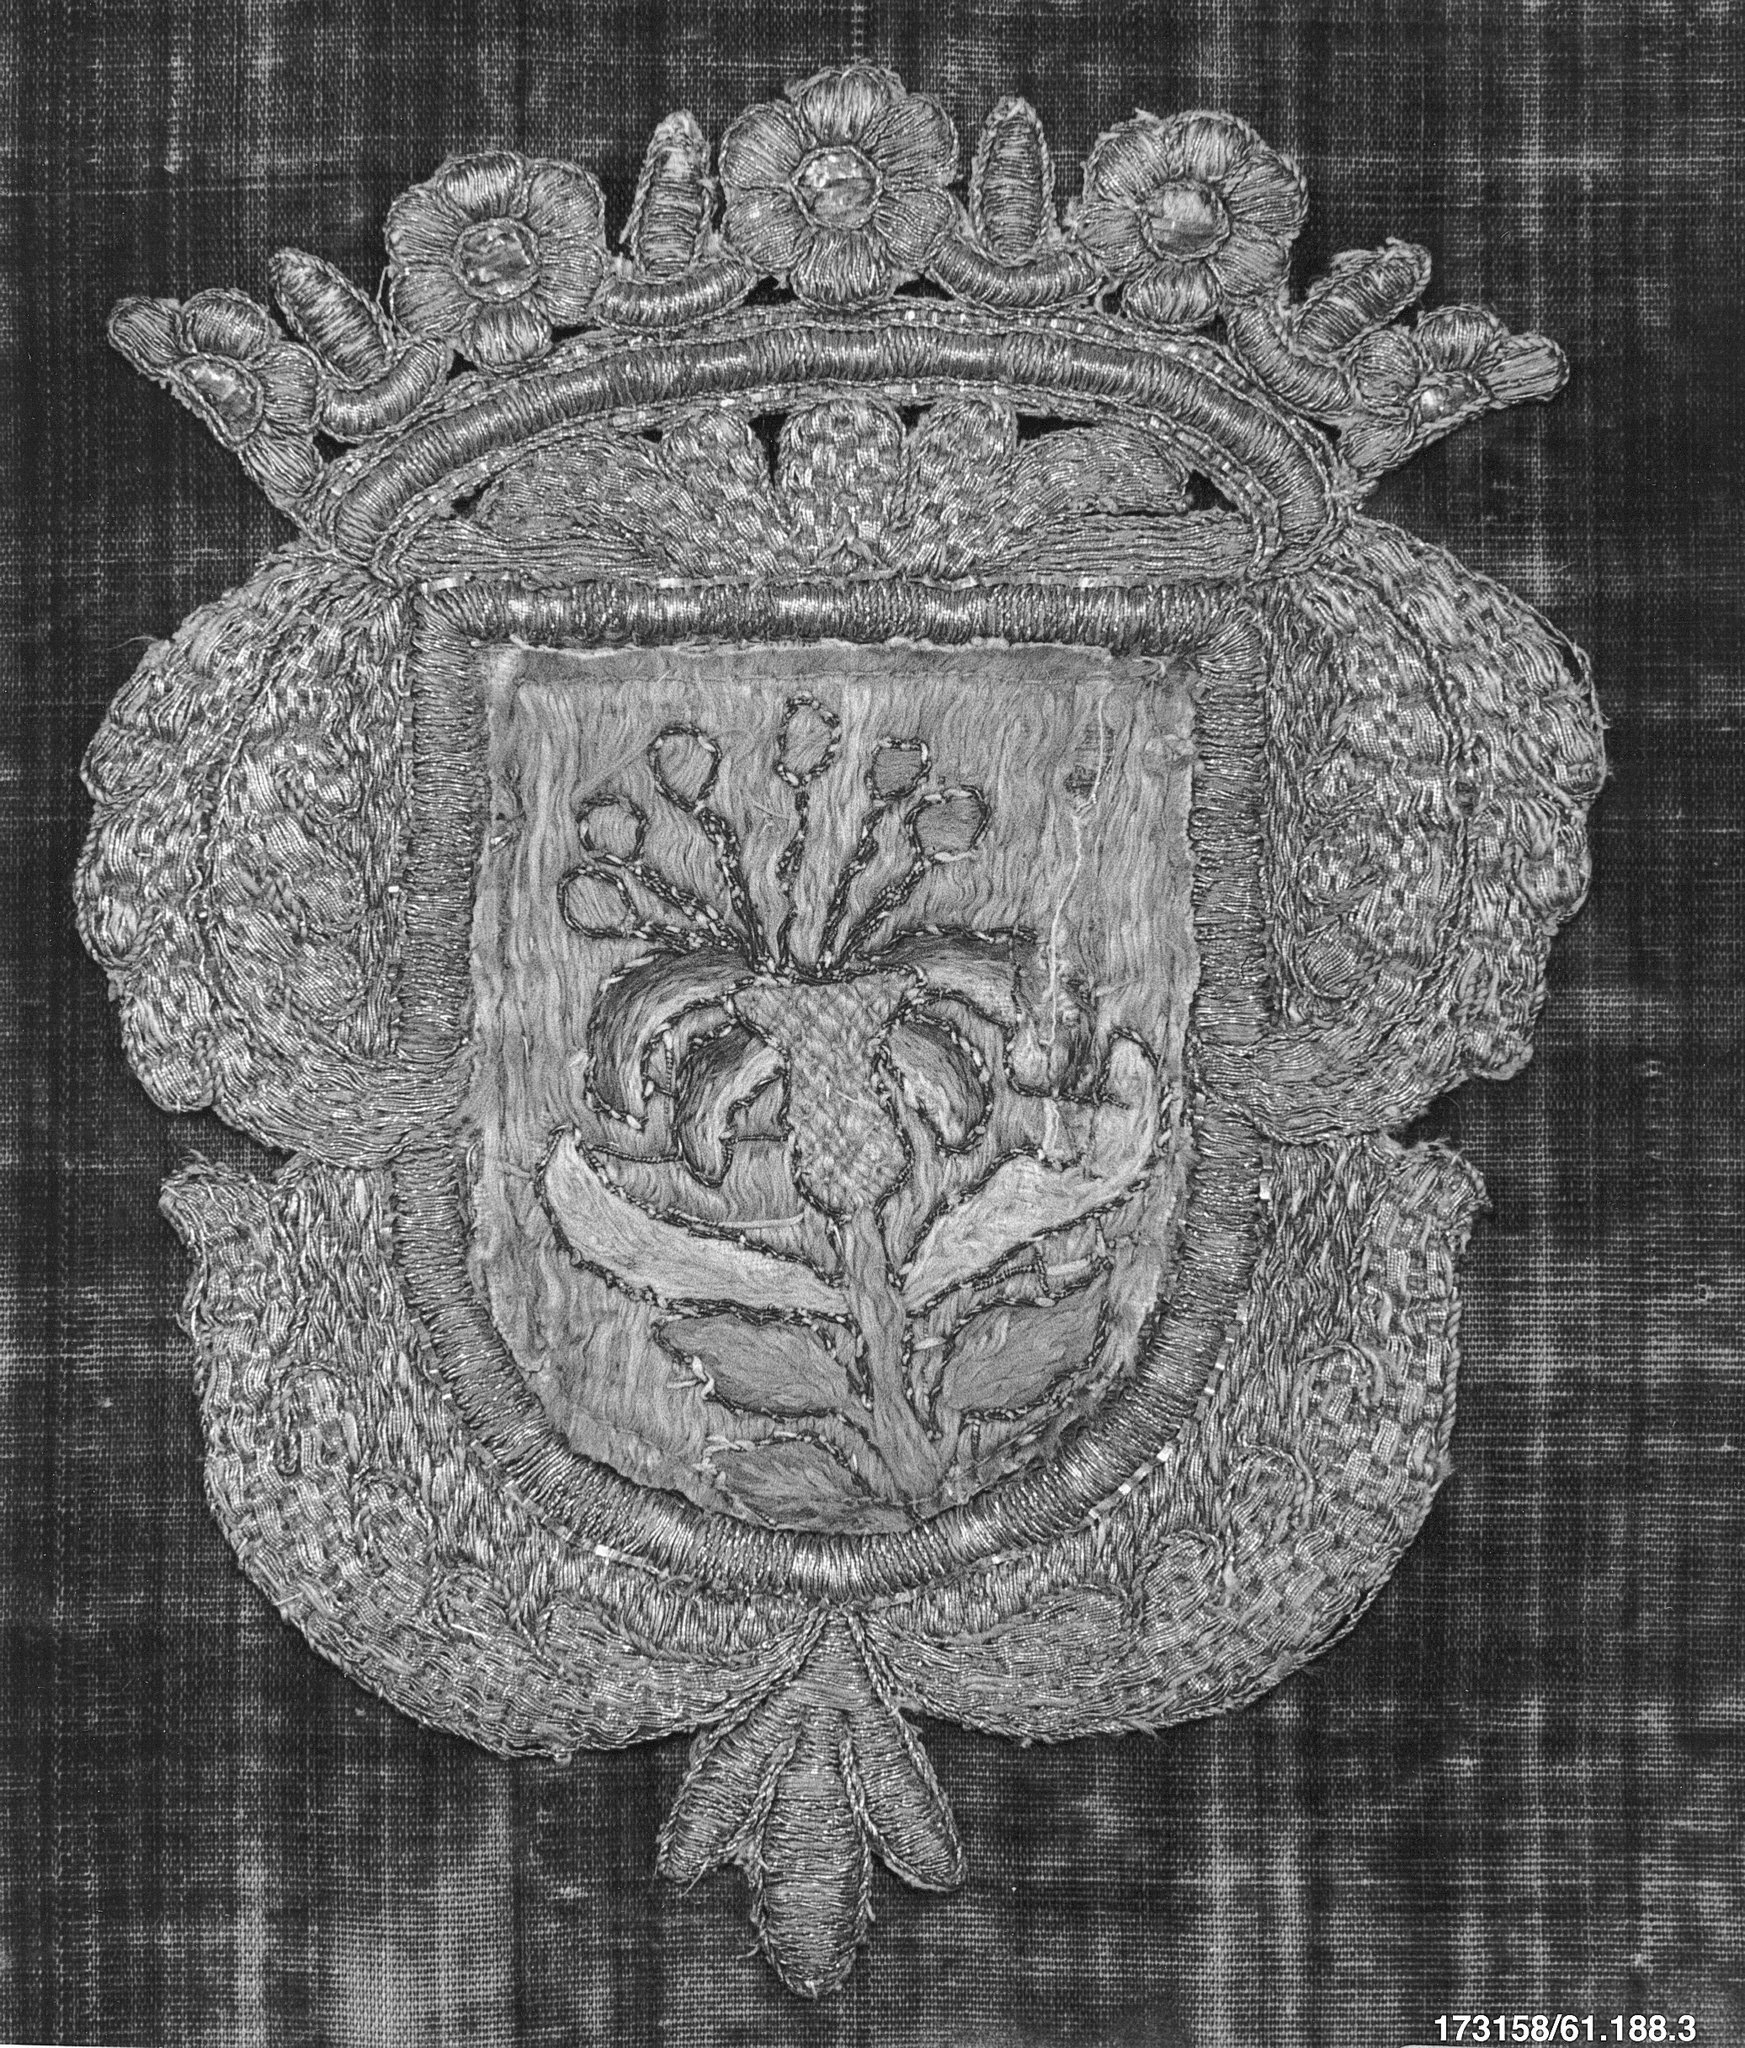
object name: coat of arm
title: Coat of arms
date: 1601-1700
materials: metal thread, silk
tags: coat of arms